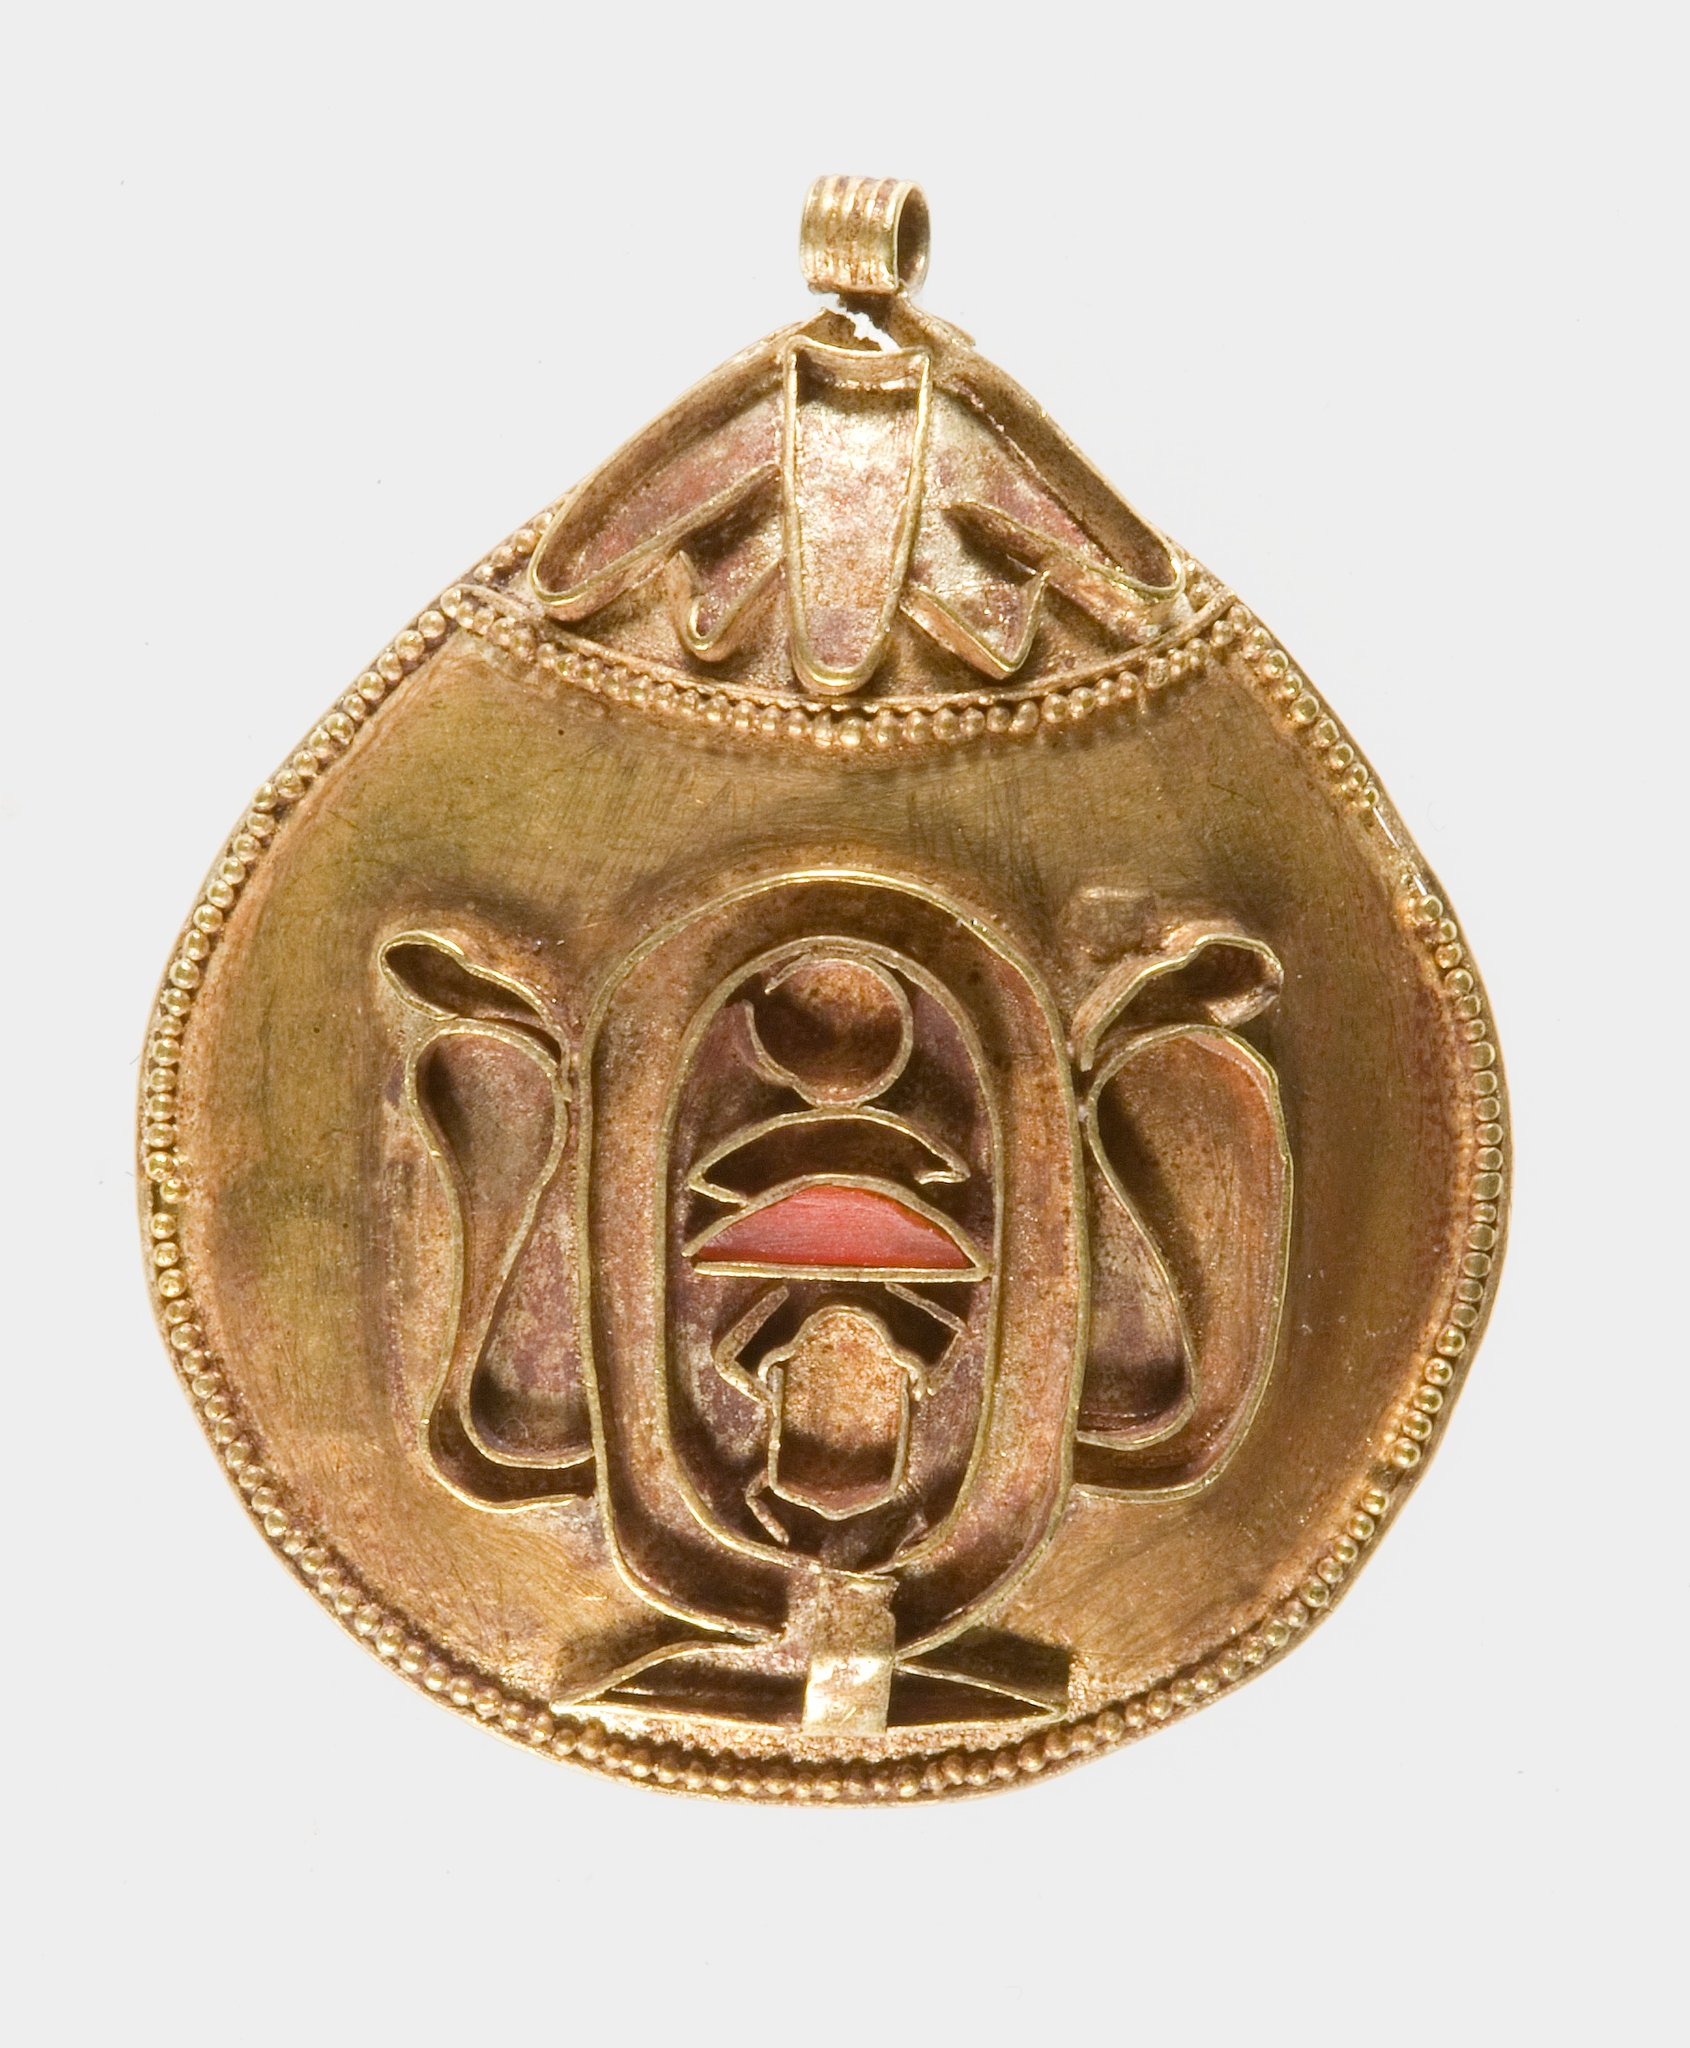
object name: pendant, shell, senwosret ii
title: Shell Pendant with the Name of Senwosret II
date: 1887-1878 BCE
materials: gemstone, gold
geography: memphite region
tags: cartouches,hieroglyphs